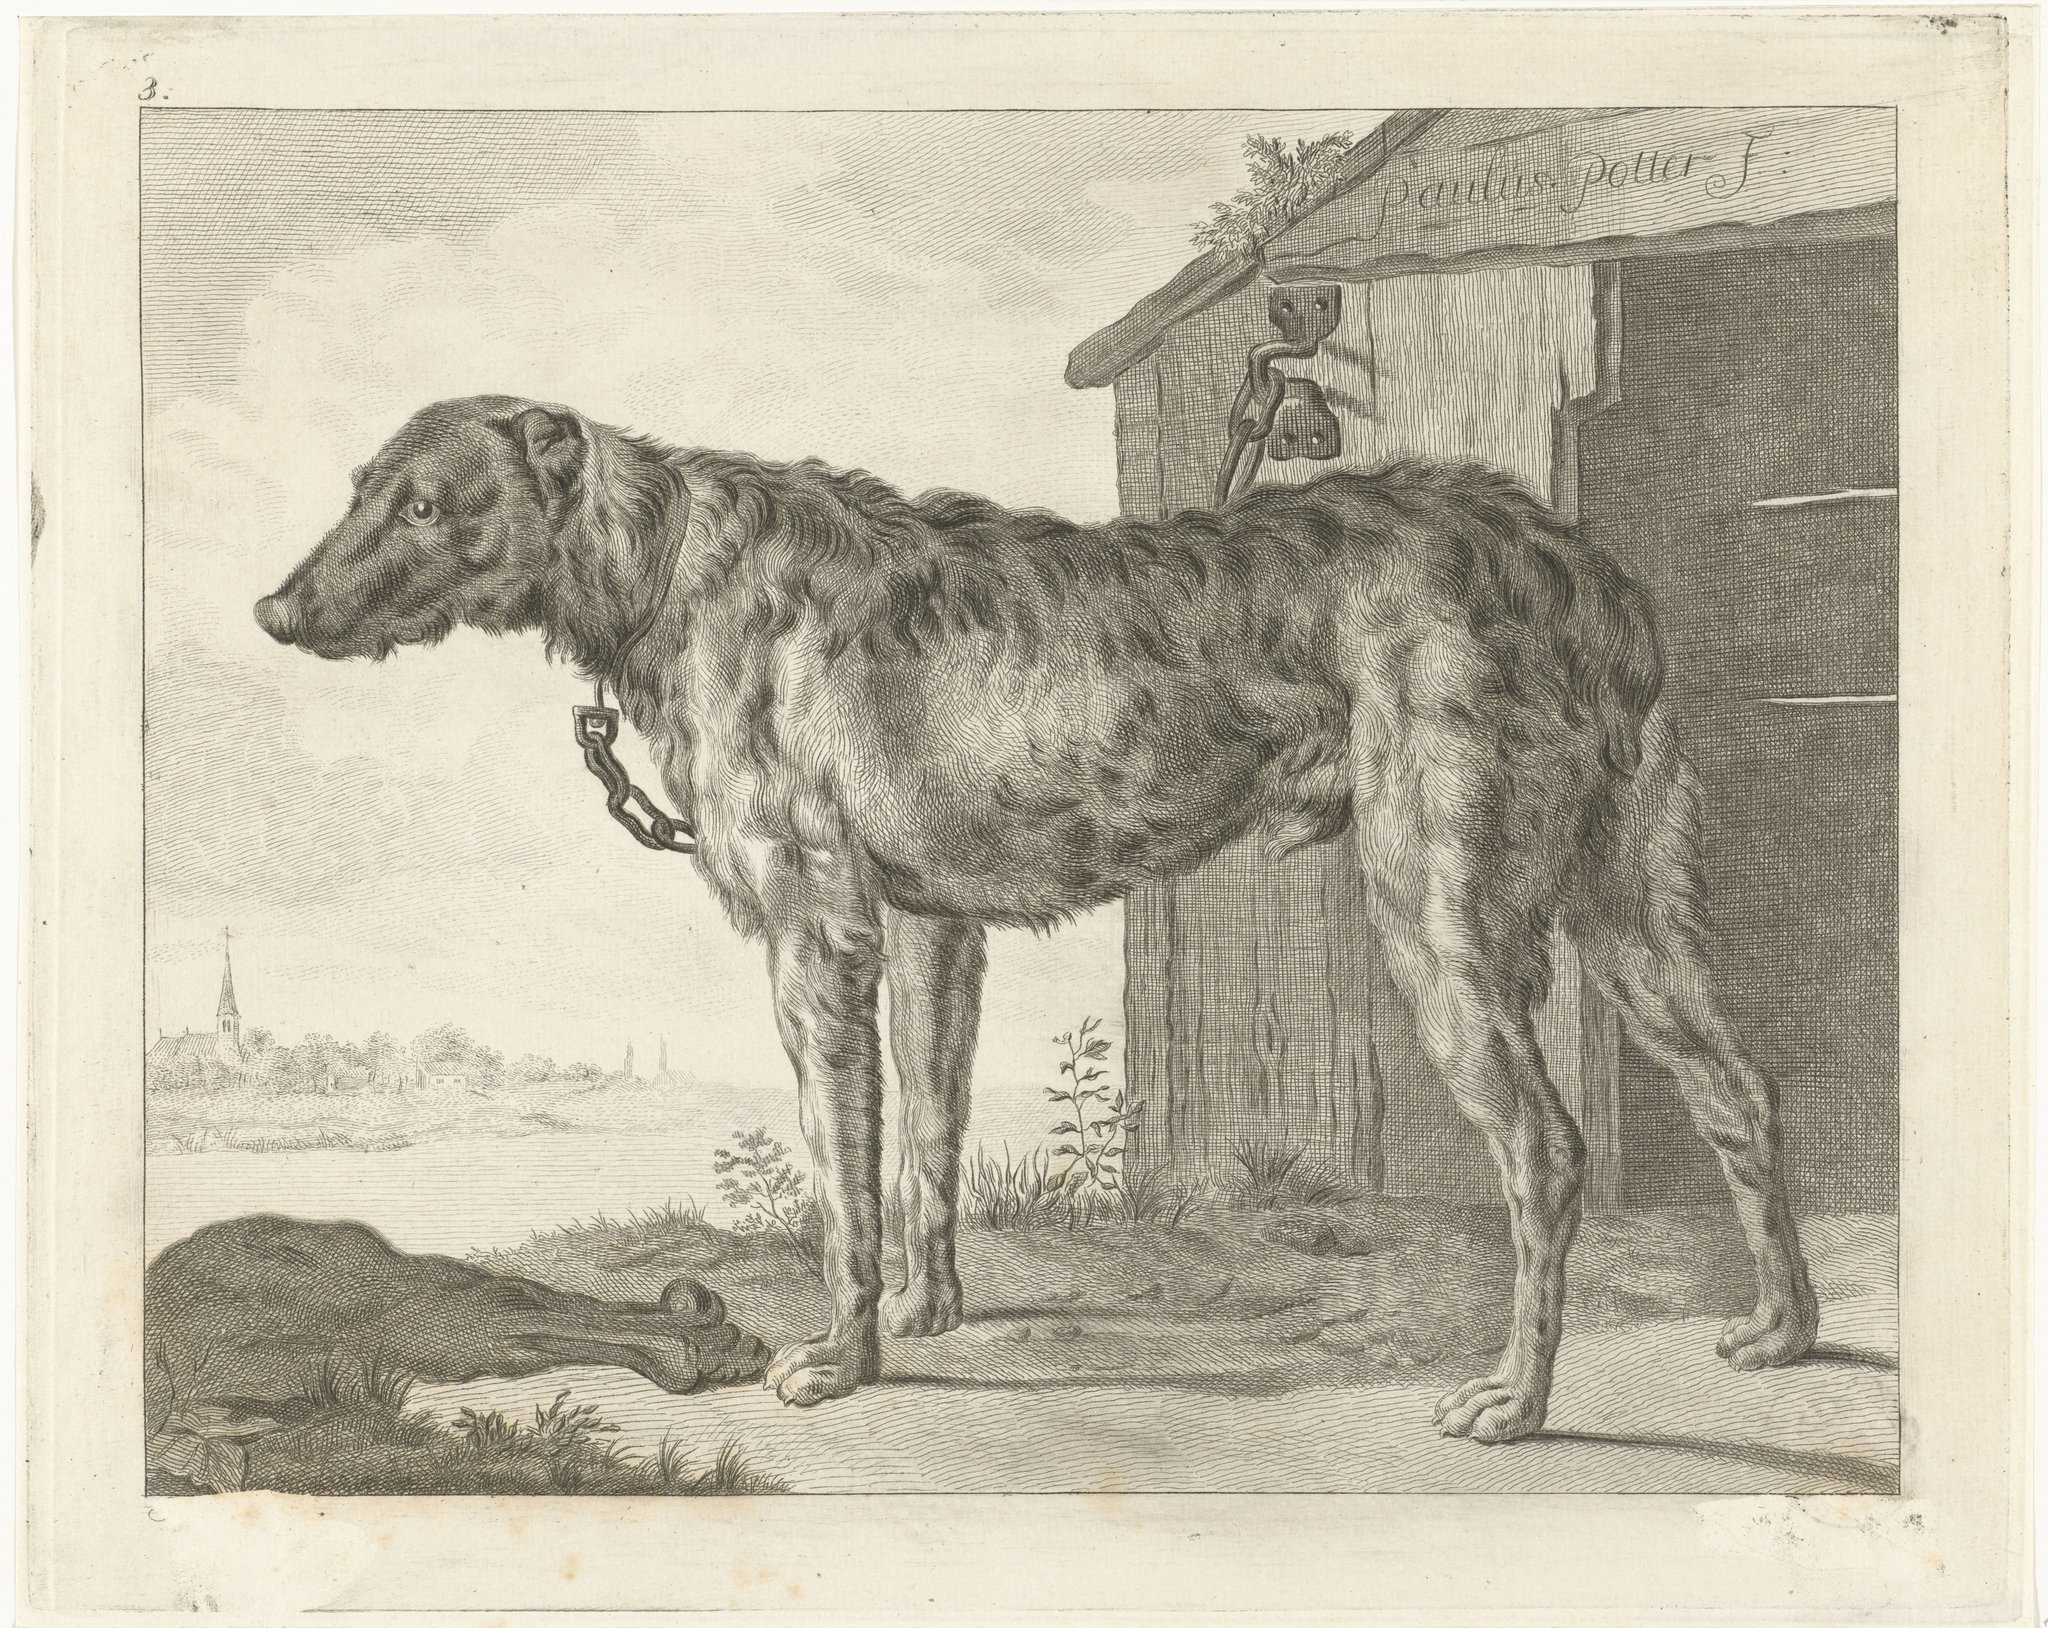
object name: print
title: Hond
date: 1768-1796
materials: paper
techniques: engraving, etching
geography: leiden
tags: dog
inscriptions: collector's mark: Lugt 240